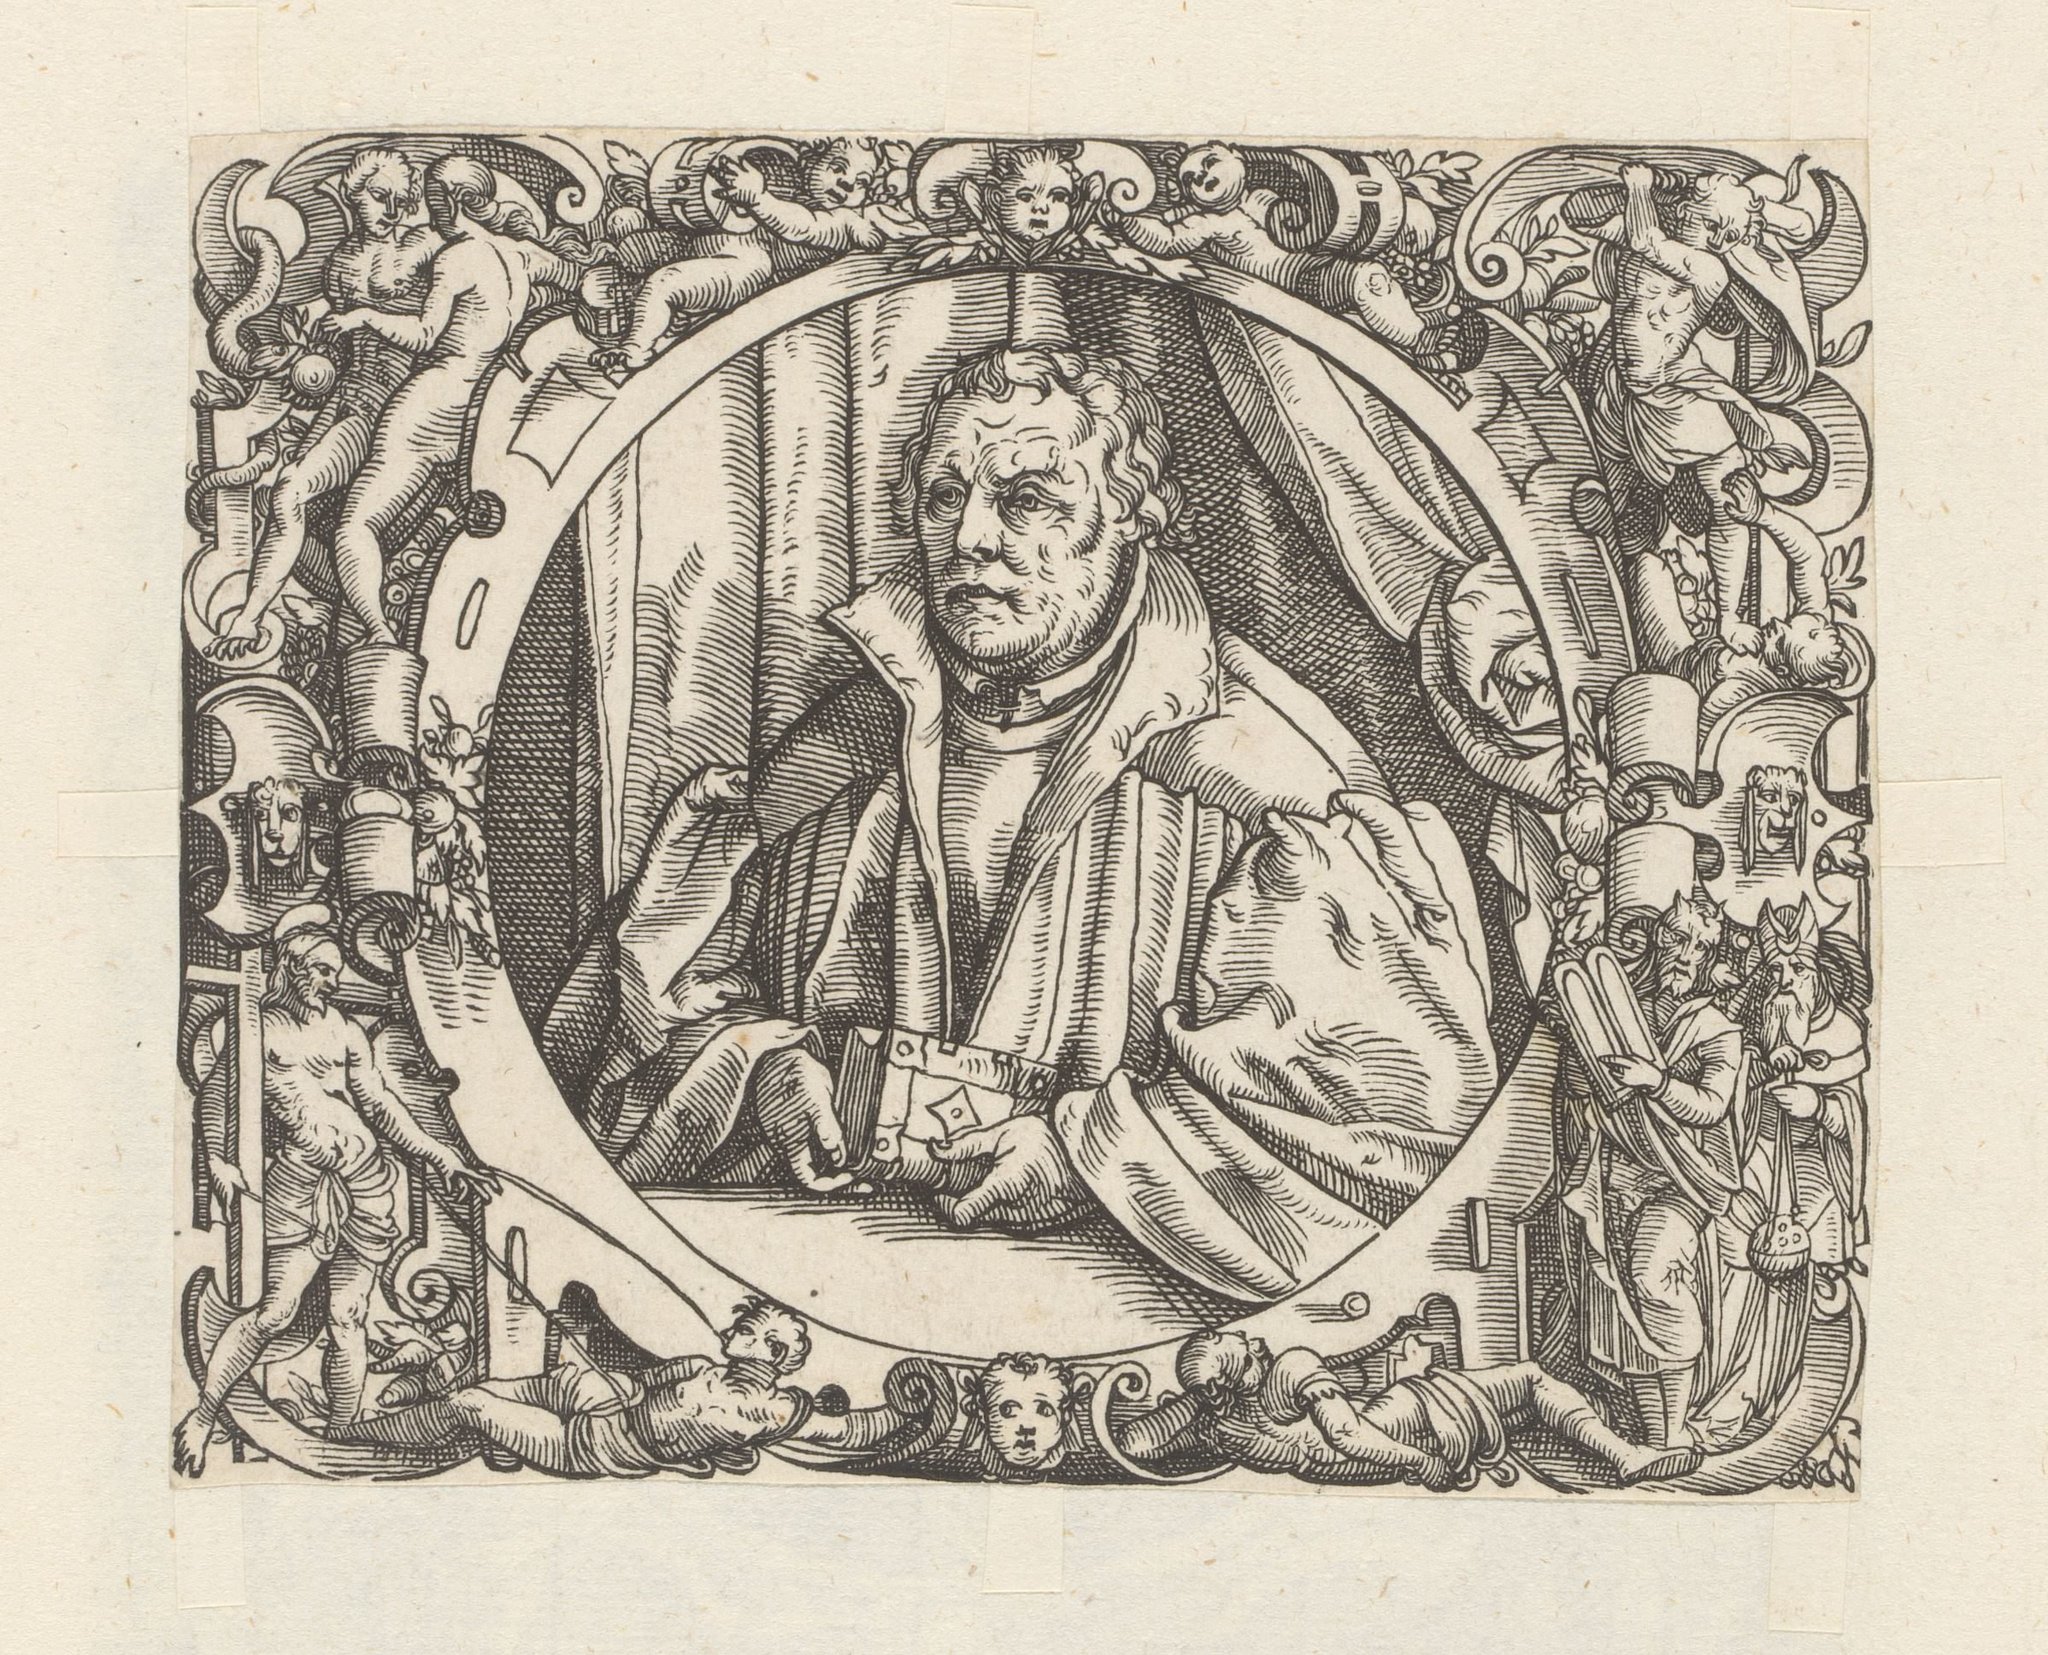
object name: album leaf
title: Portret van een onbekende man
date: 1549-1584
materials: paper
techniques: woodcut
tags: theologian, historical persons